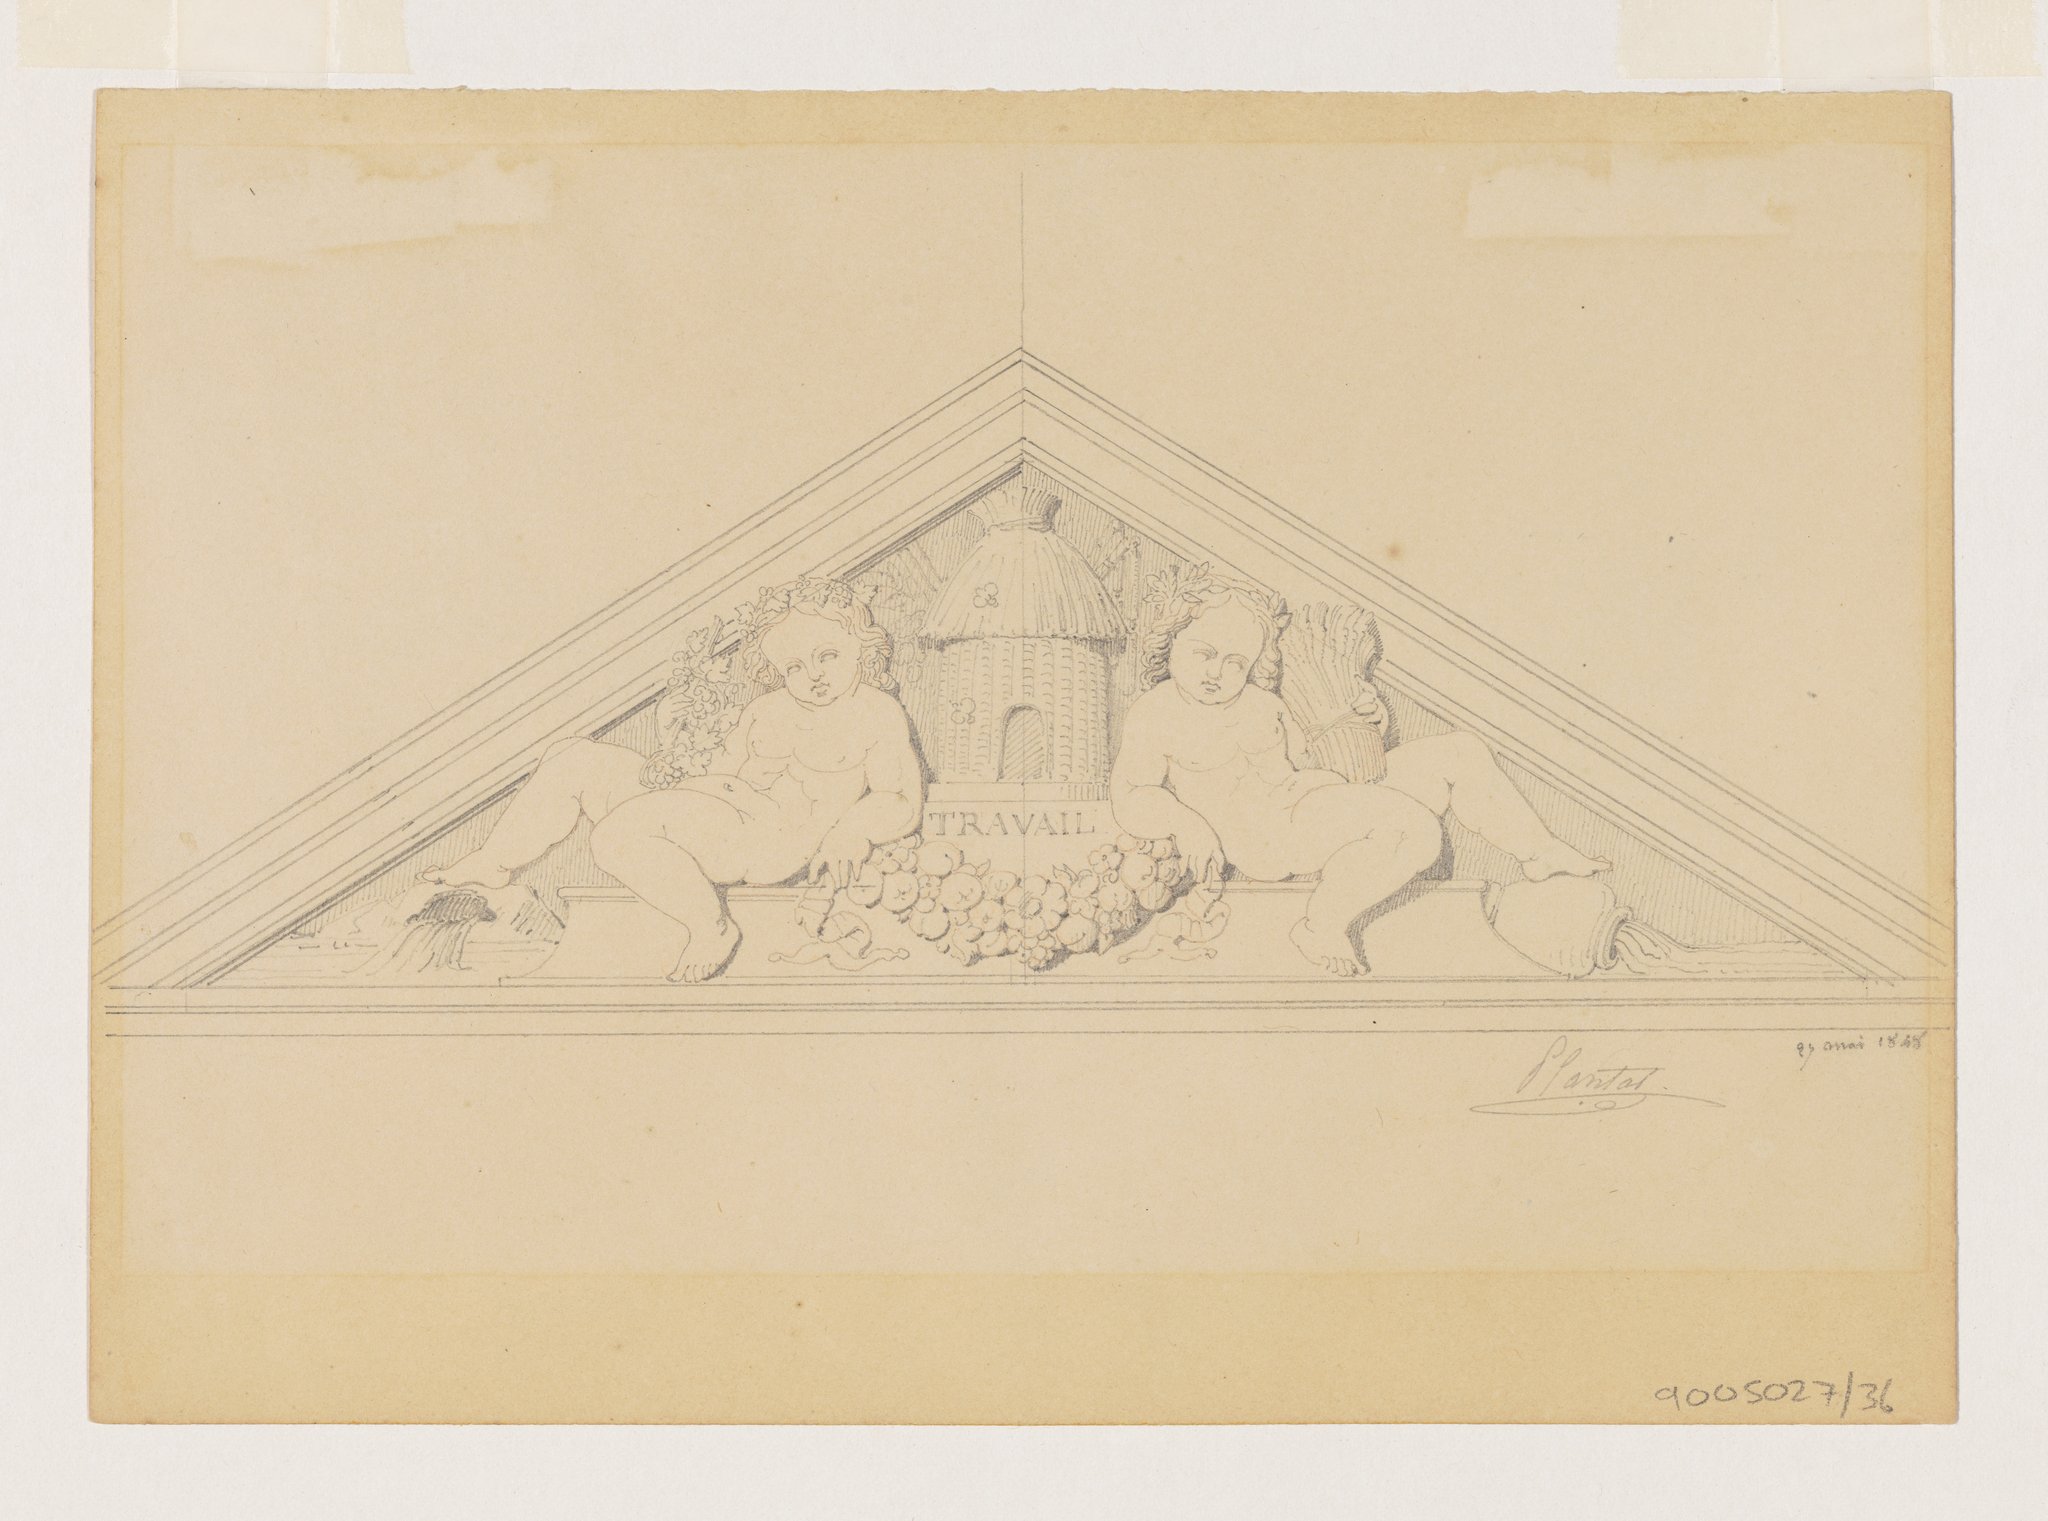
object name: drawing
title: Design for a Pediment dedicated to Labor (Travail)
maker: jean-baptiste louis plantar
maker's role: artist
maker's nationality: french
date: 1834-1866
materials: graphite, ink, watercolor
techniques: pen